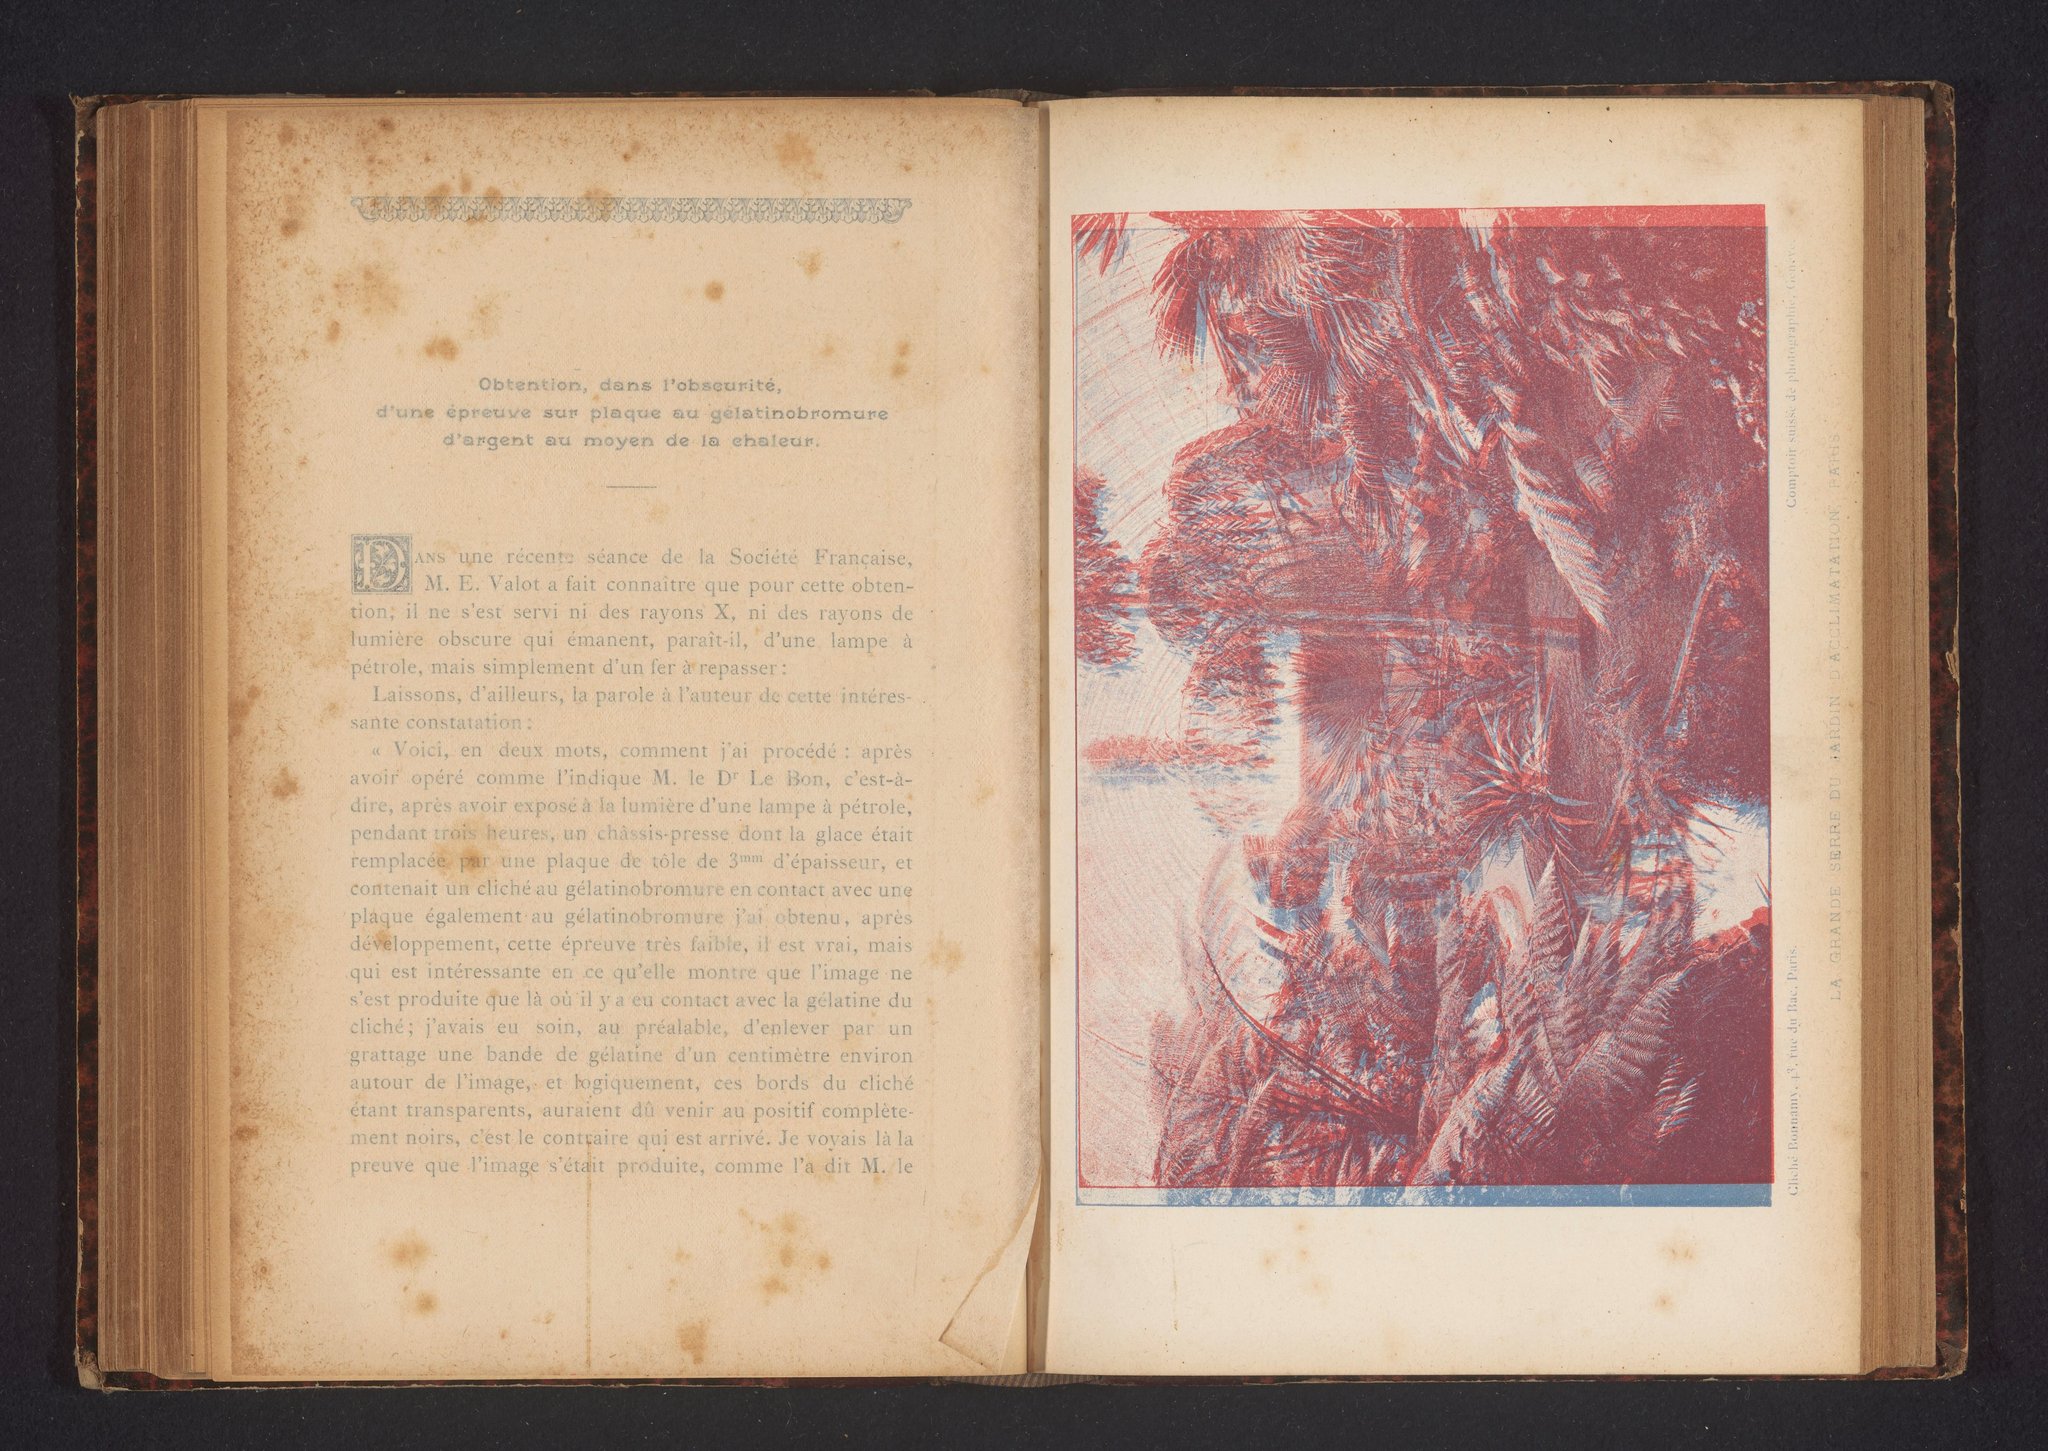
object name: anaglyph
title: La Grande Serre du Jardin d'Acclimatation, Paris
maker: bonnamy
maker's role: clichémaker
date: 1891-1896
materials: paper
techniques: two-color autotype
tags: botanic garden, 'hortus botanicus', paris